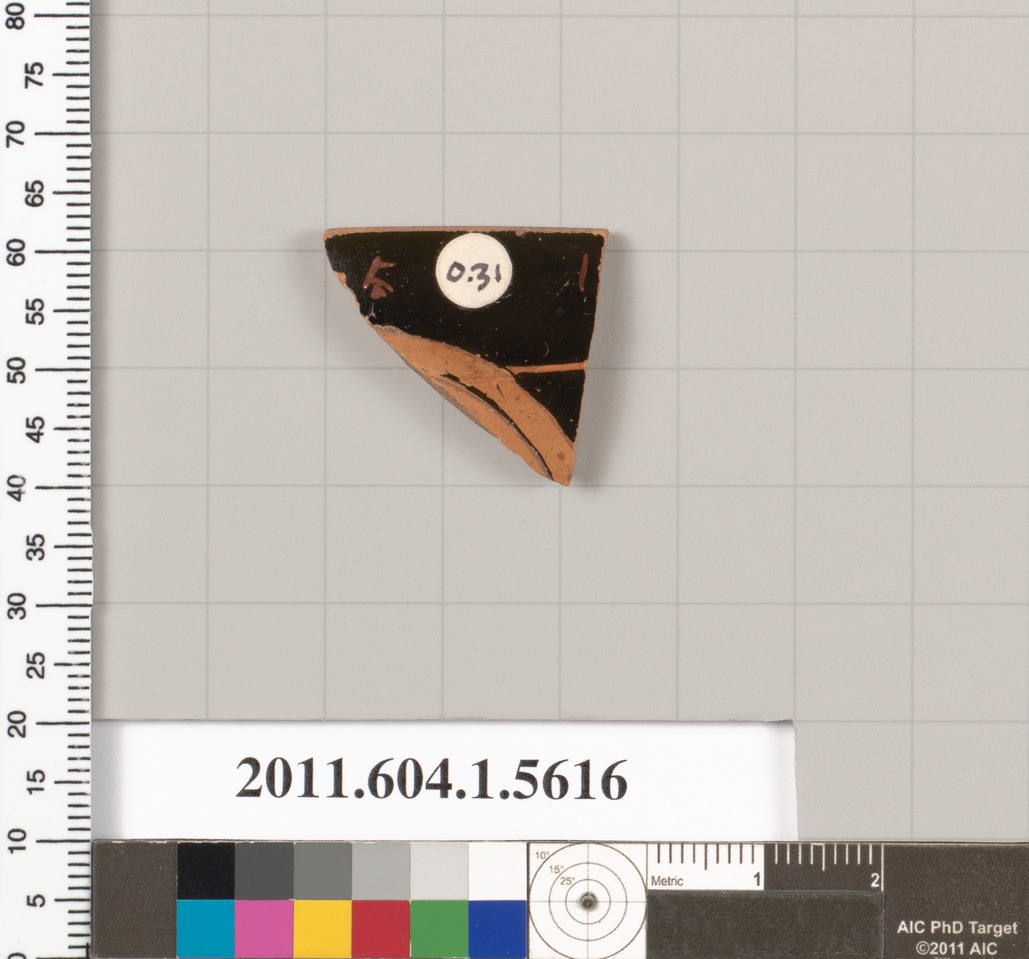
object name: kylix fragment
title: Terracotta rim fragment of a kylix (drinking cup)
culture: greek, attic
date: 510-490 BCE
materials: terracotta